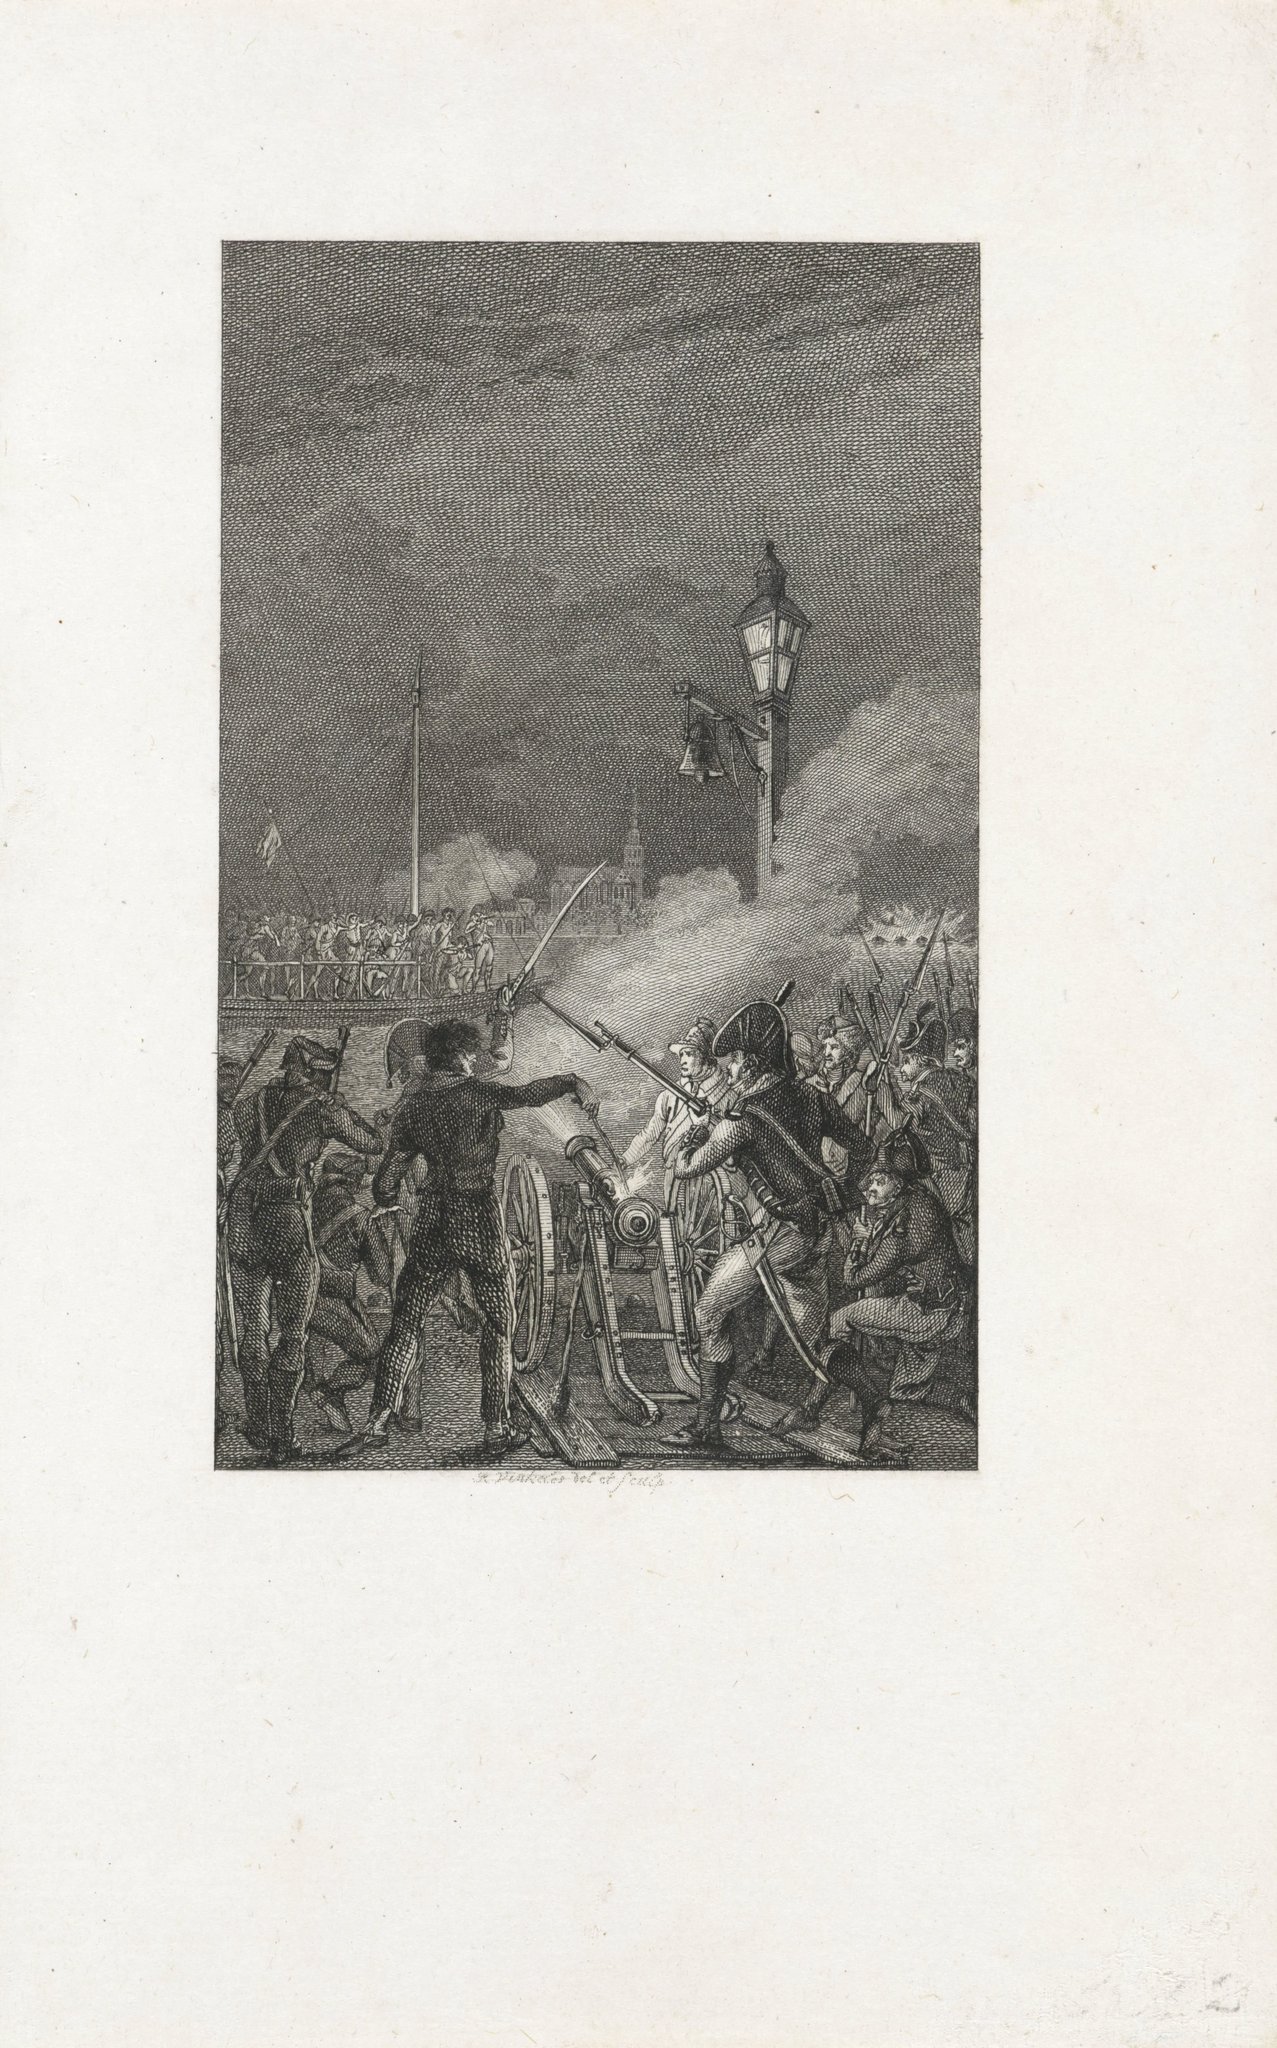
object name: print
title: Fransen beschieten de vluchtende troepen op de Gierbrug, 1794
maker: reinier vinkeles (i)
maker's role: draughtsman, print maker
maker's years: 1741-1816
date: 1799-1801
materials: paper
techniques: engraving, etching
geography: northern netherlands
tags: retreat of the defeated, nijmegen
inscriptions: collector's mark: Lugt 2228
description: Gebruikt als illustratie in: P.A. Loosjes. Vaderlandsche historie, vervattende de geschiedenissen, der Vereenigde Nederlanden (...). Ten onmiddelyken vervolge van Wagenaar's Vaderlandsche historie. Amsterdam: Johannes Allart, dl. 27 (1801).